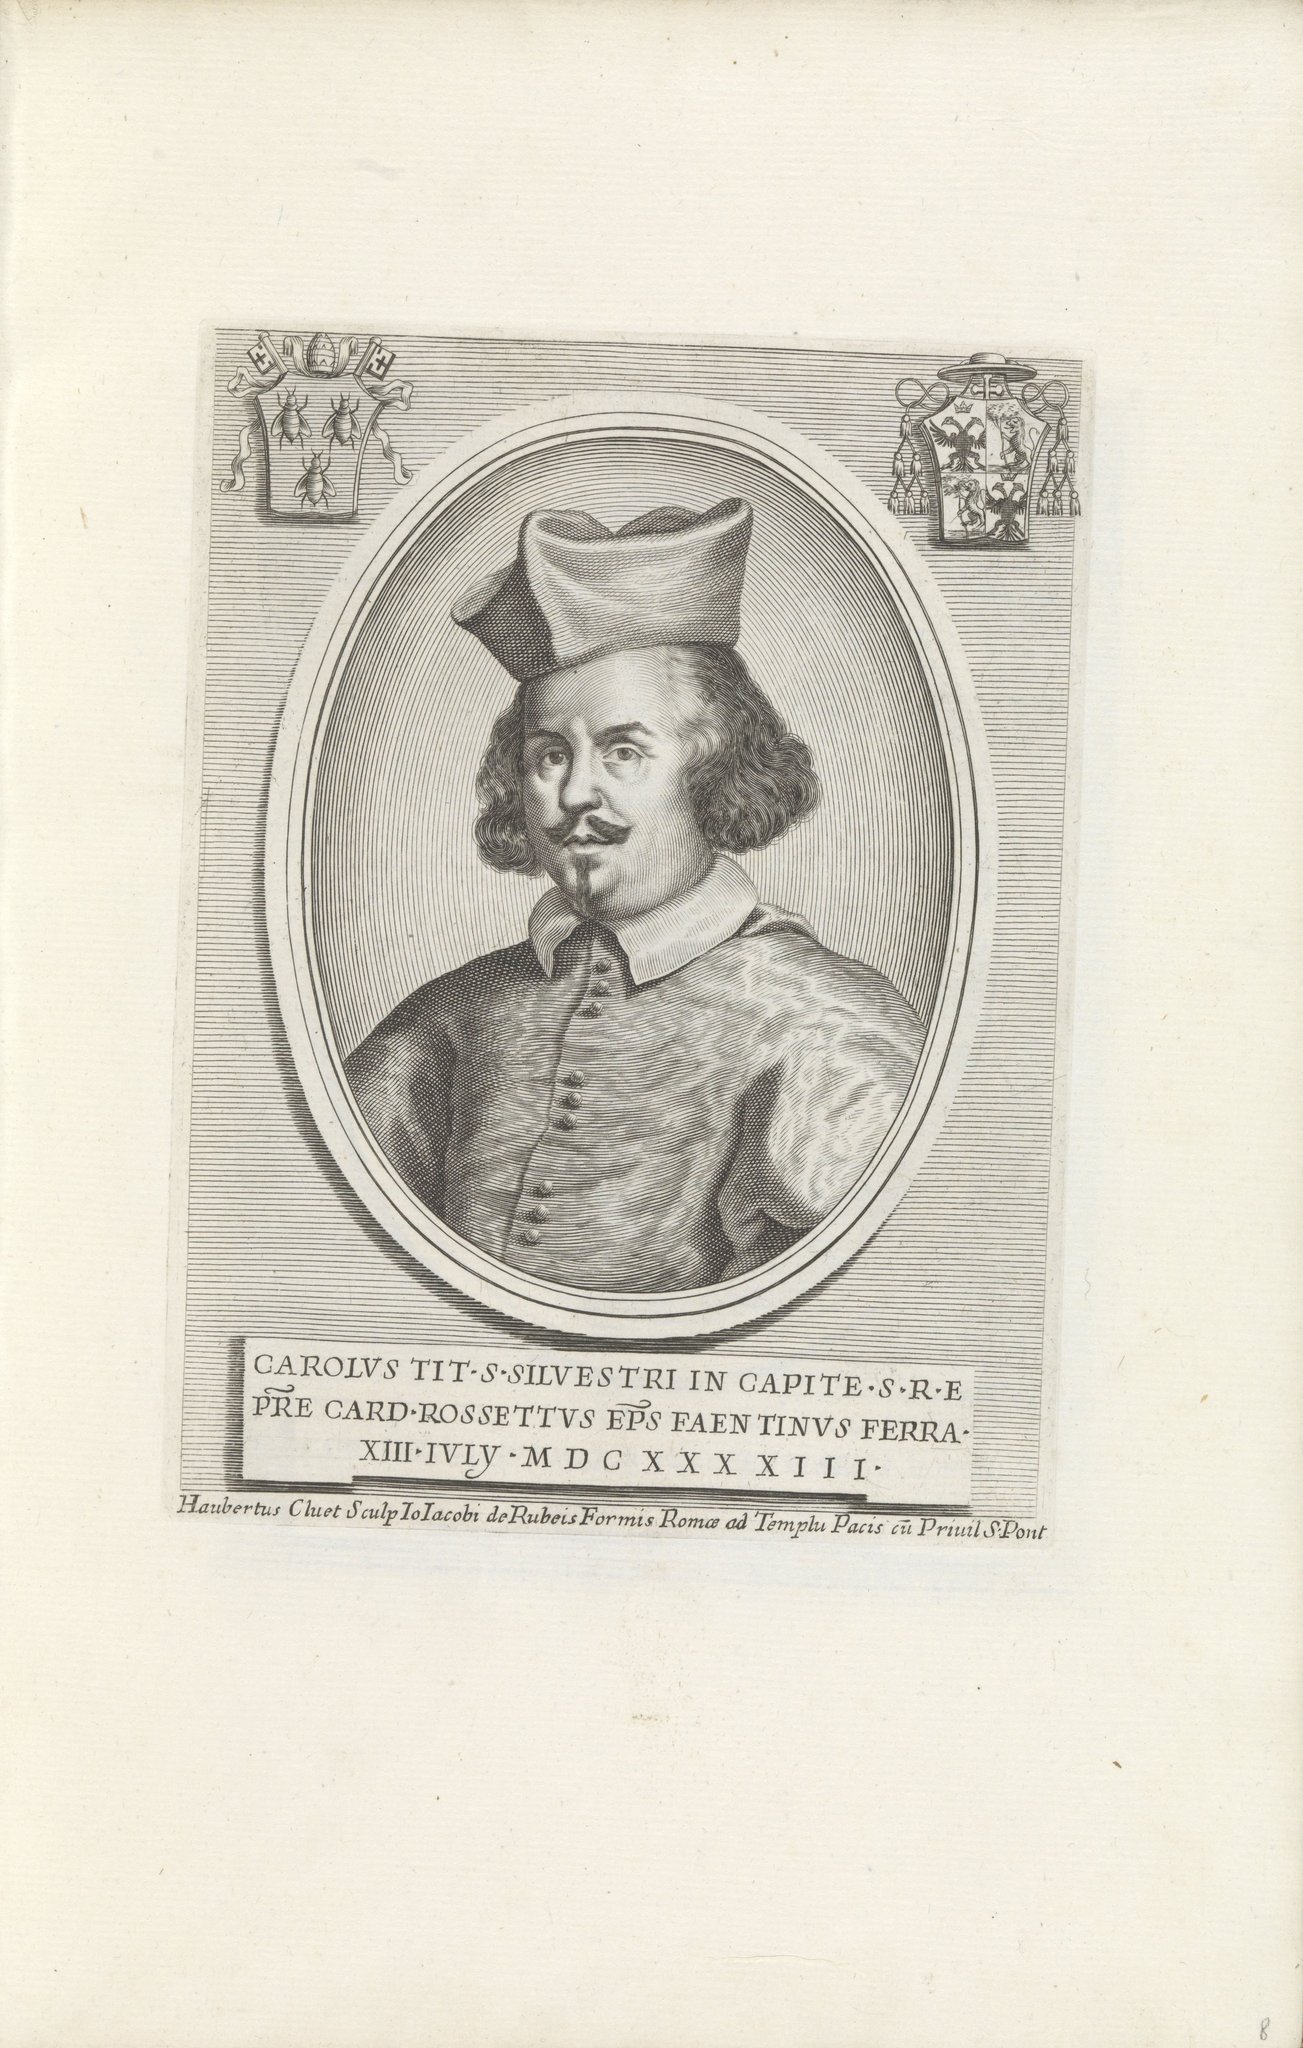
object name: album leaf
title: Effigies Nomina et Cognomina S.D.N. Alexandri Papae VII et RR. DD. SRE. Cardd (...).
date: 1658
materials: paper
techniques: engraving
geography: rome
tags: cardinal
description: Portret van kardinaal Carlo Rossetti. Linksboven het wapen van paus Urbanus VIII en rechtsboven het wapen van kardinaal Rossetti. Onderaan een onderschrift in het Latijn. De prent maakt deel uit van een album.